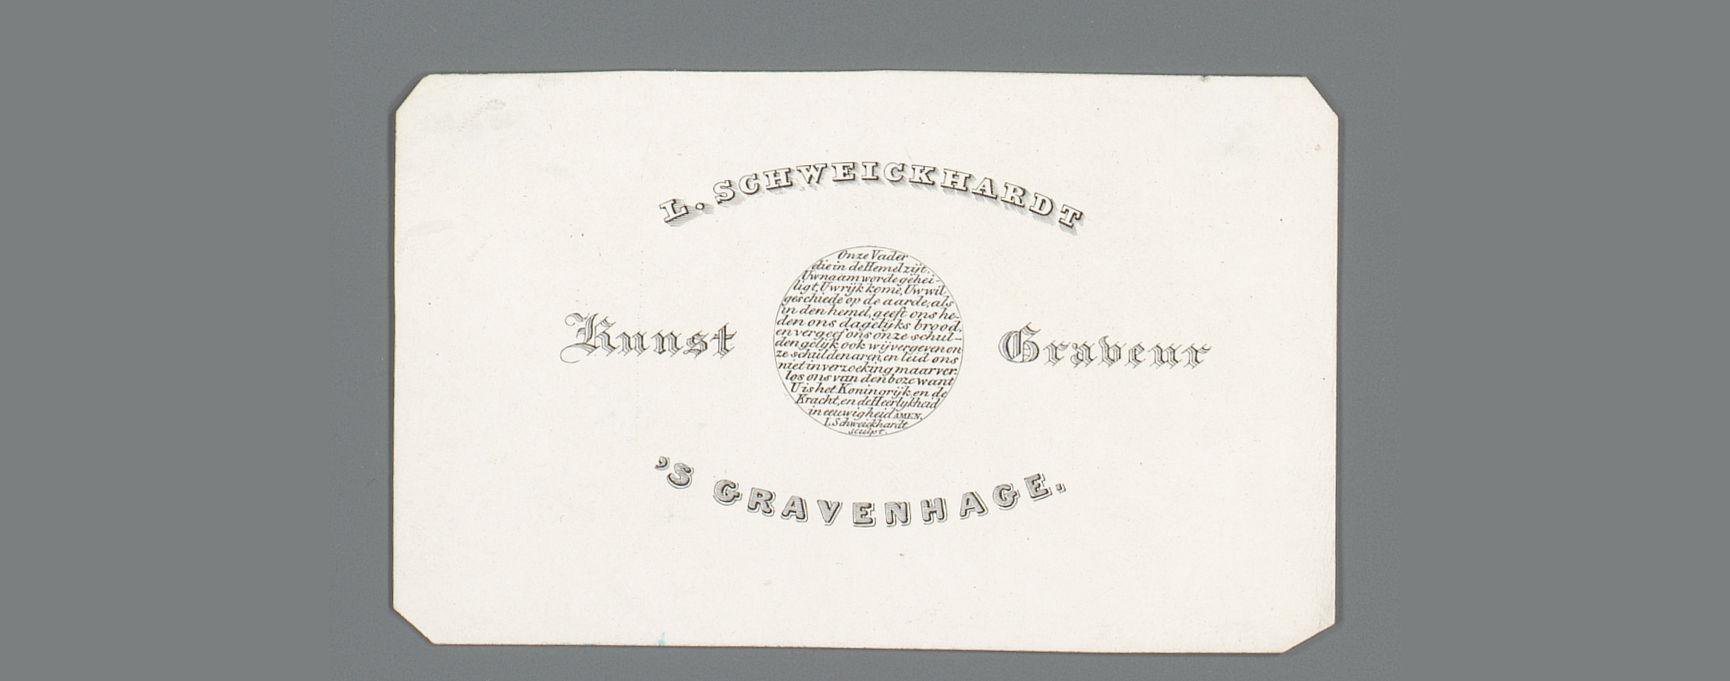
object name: business card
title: Adreskaart van Leonardus Schweickhardt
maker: leonardus schweickhardt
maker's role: print maker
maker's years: 1783-1862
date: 1793-1862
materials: porcelainized cardboard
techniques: engraving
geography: the hague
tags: print maker, leonardus schweickhardt, 'our father which art in heaven' ~ the lord's prayer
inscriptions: collector's mark: Lugt 2165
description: In een kleine cirkel (diameter ca. 15 millimeter) is het Onzevader gegraveerd, met daarbij: 'L. Schweickhardt Kunst Graveur 's Gravenhage'.